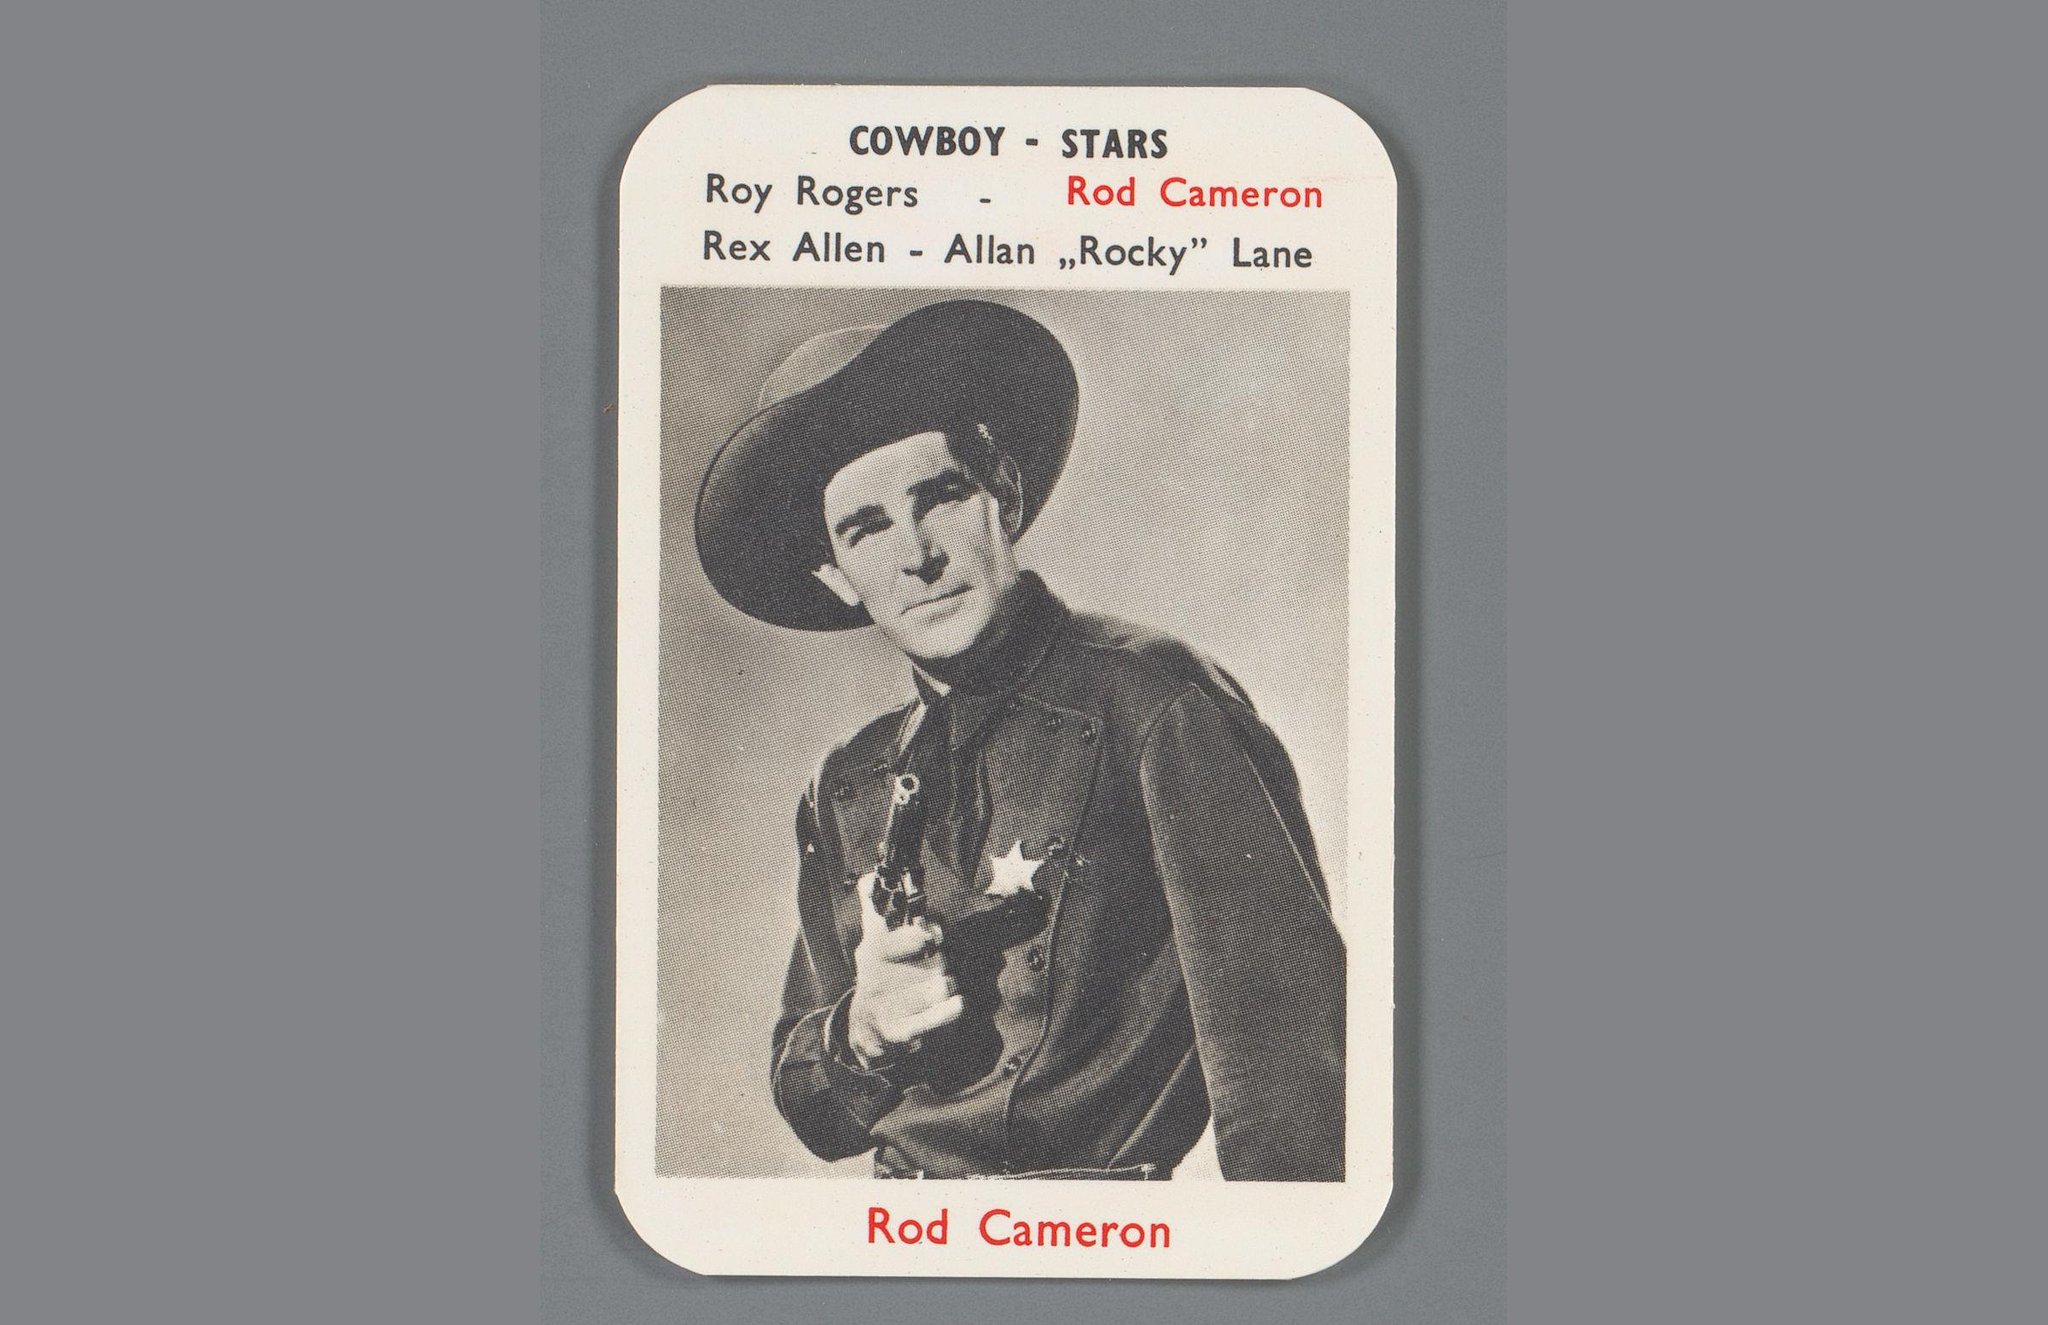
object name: playing card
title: Portret van Rod Cameron; onderdeel van het kwartet Cowboy-Stars uit een kwartetspel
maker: Anonymous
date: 1960-1970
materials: paper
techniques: autotype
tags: portrait of actor, actress